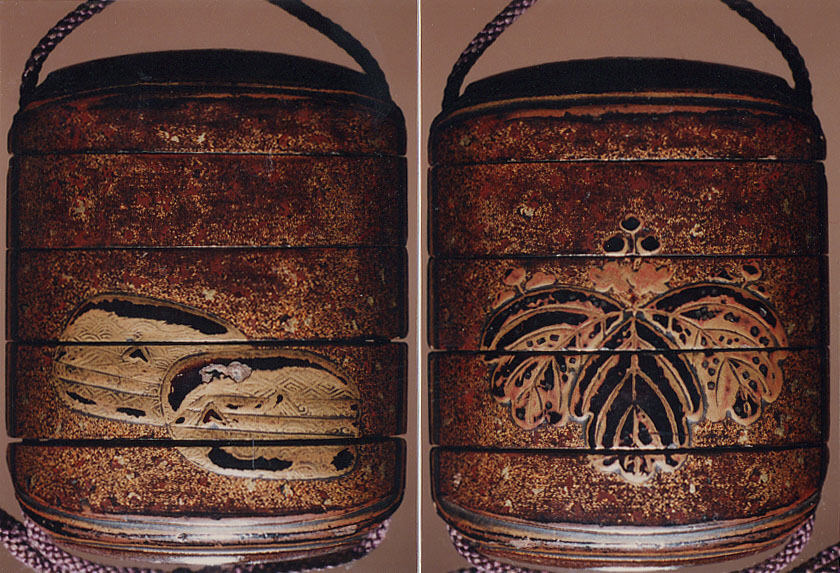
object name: inrō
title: Case (Inrō) with Design of Large Kiri Mon (obverse); Two Brocade Pouches (reverse)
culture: japanese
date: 1701-1800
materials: gold, lacquer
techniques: fundame, hiramakie, maki-e